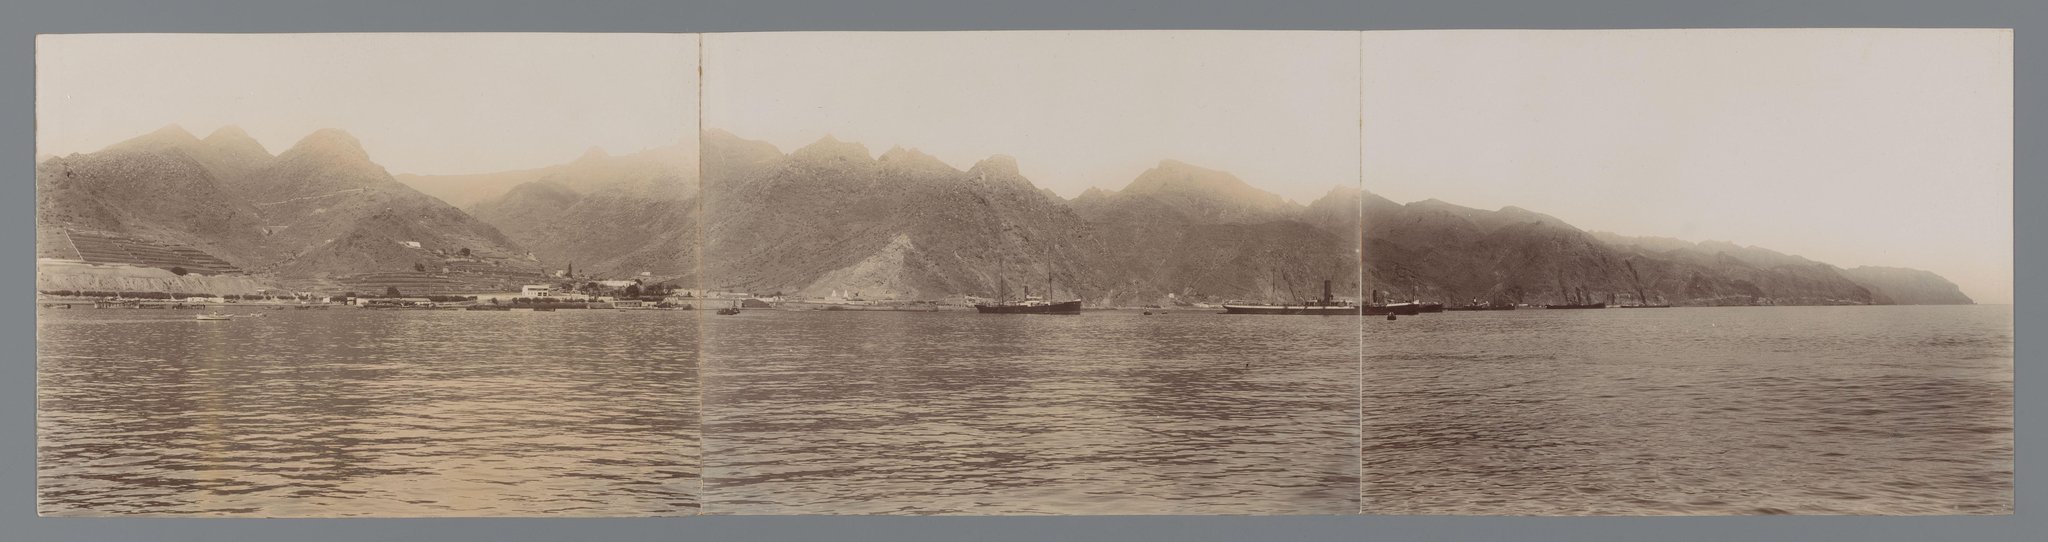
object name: photograph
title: Tenerife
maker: jordão da luz perestrello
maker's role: fotograaf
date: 1860-1915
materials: paper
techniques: gelatin silver print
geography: tenerife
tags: tenerife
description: Het object bestaat uit drie aaneen geplakte foto's van de kustlijn van Tenerife.